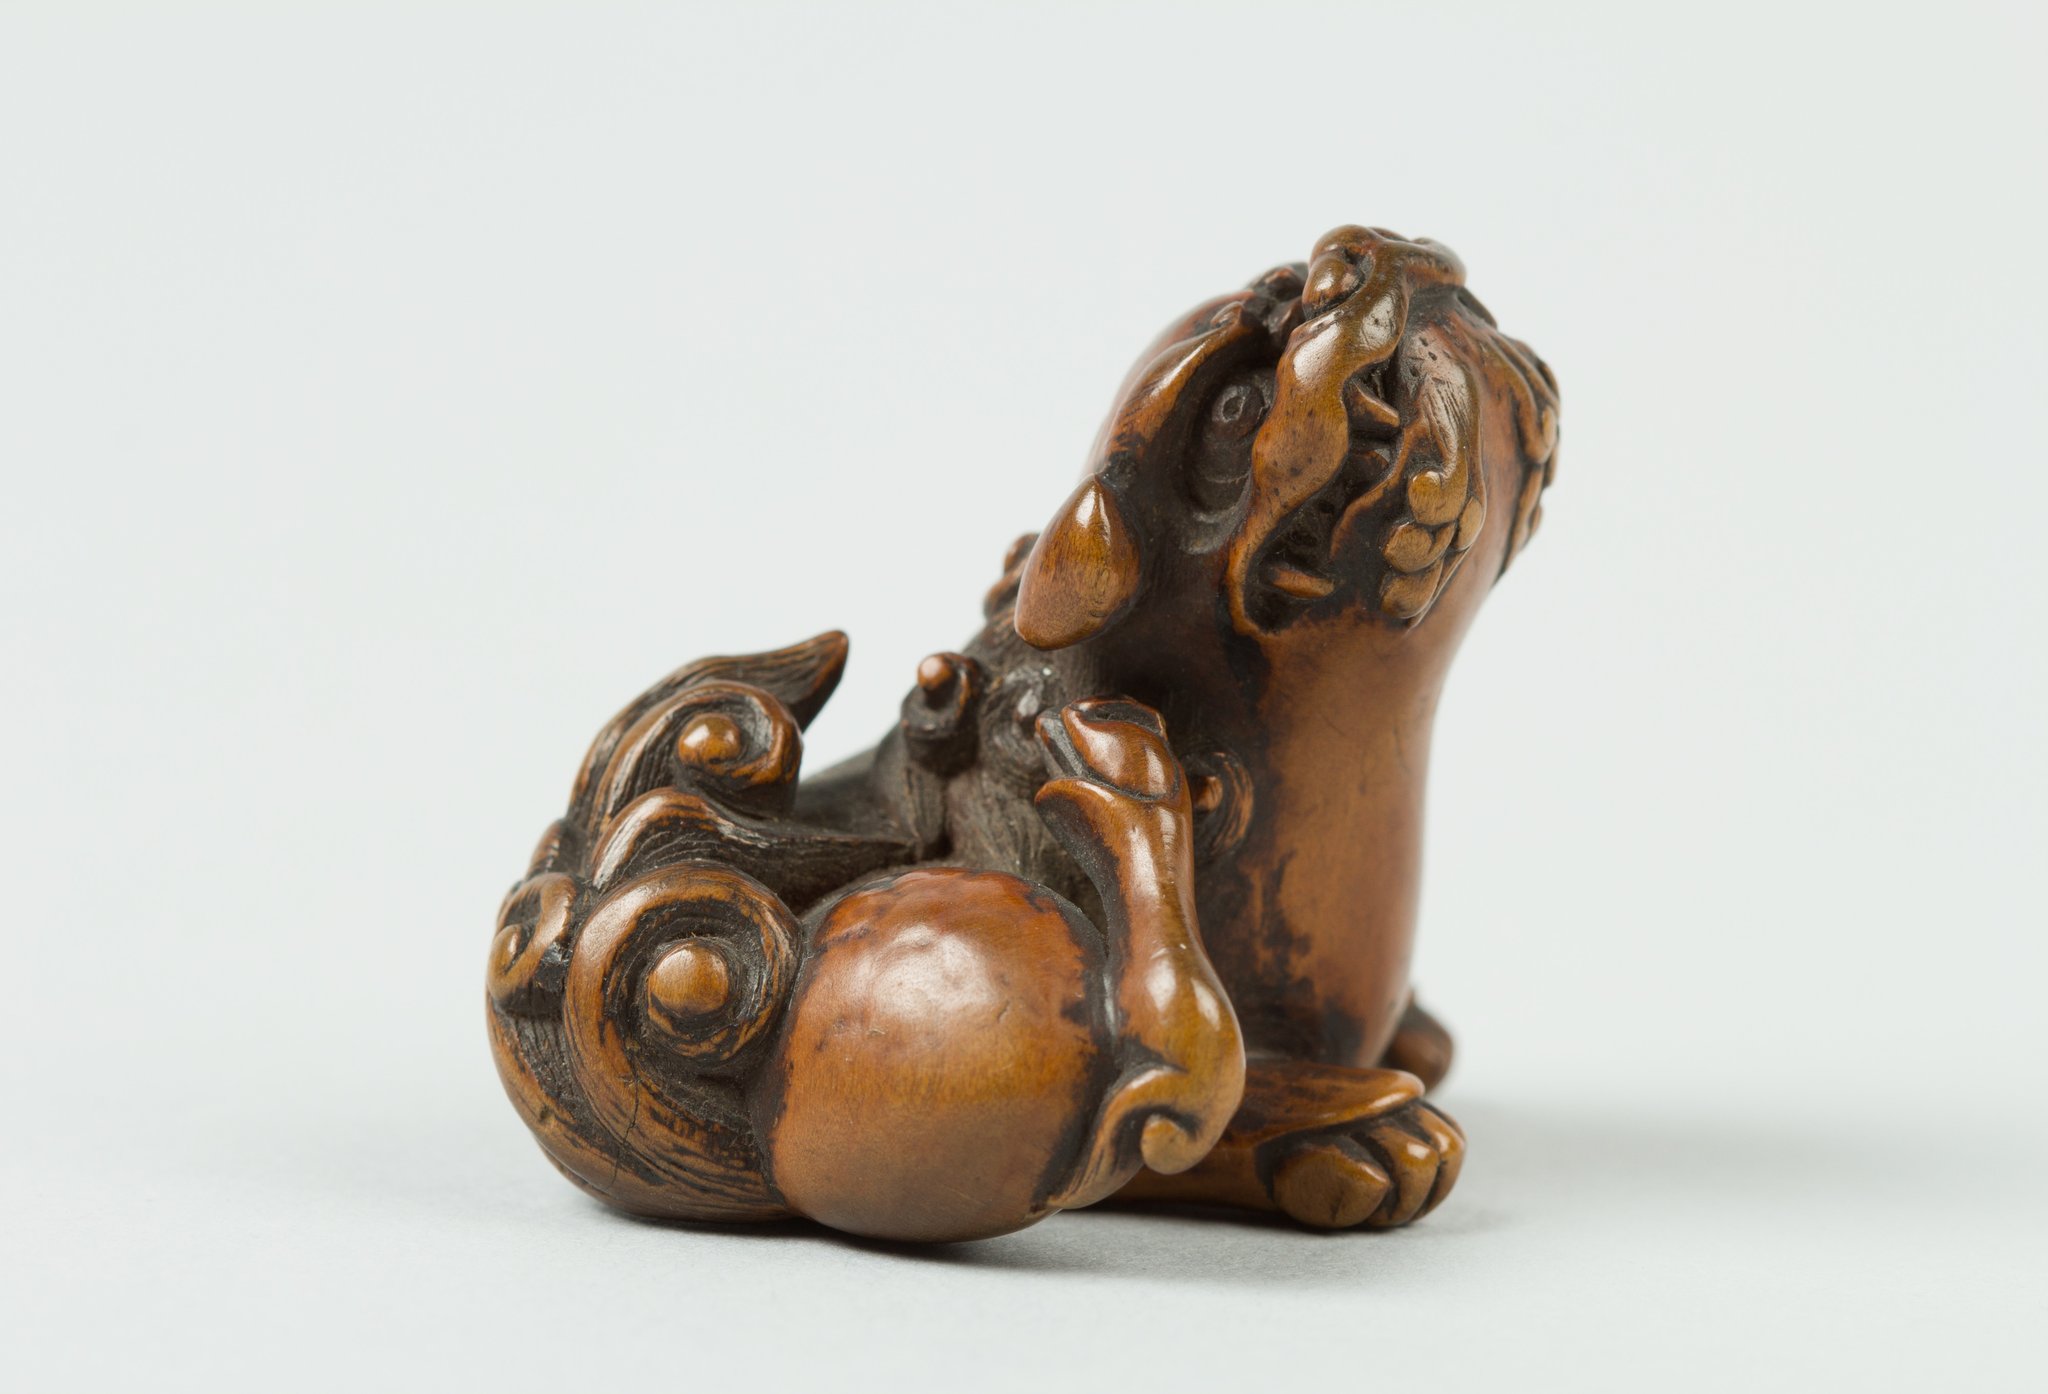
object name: netsuke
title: Netsuke of Qilin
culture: japanese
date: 1701-1800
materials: wood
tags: mythical creatures